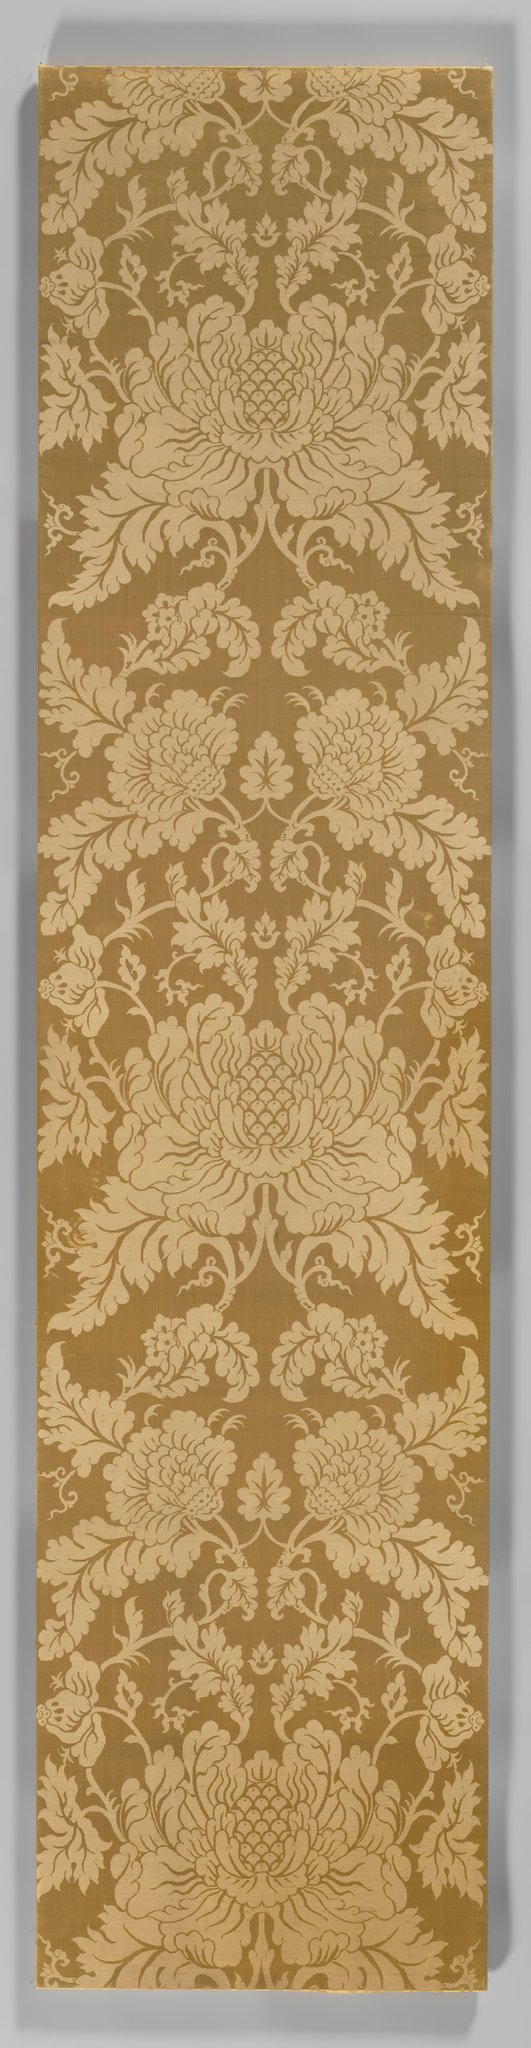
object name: silk textile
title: Wandbespanning van geel zijden damasten met symmetrisch patroon van twee opgaande golvende ranken met onder andere pioenvormige bloemen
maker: Anonymous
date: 1700-1725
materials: silk, wood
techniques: damask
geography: france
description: Geel zijden damasten wandbespanning. Symmetrisch patroon van twee opgaande golvende ranken waaraan grote pioenvormige bloemen met geschubtd hart; kleinere bloemen zijn paarsgewijs geplaatst, evenals bloemknoppen, gevederde bladeren en arabeskrankjes, die eindigen in wolkenbanden. Patroon van keperstreep, fond van satijnbinding. Afkomstig uit het pand Voorstraat 140 te Dordrecht. Eén baan heeft aan de onderkant wat waterschade.